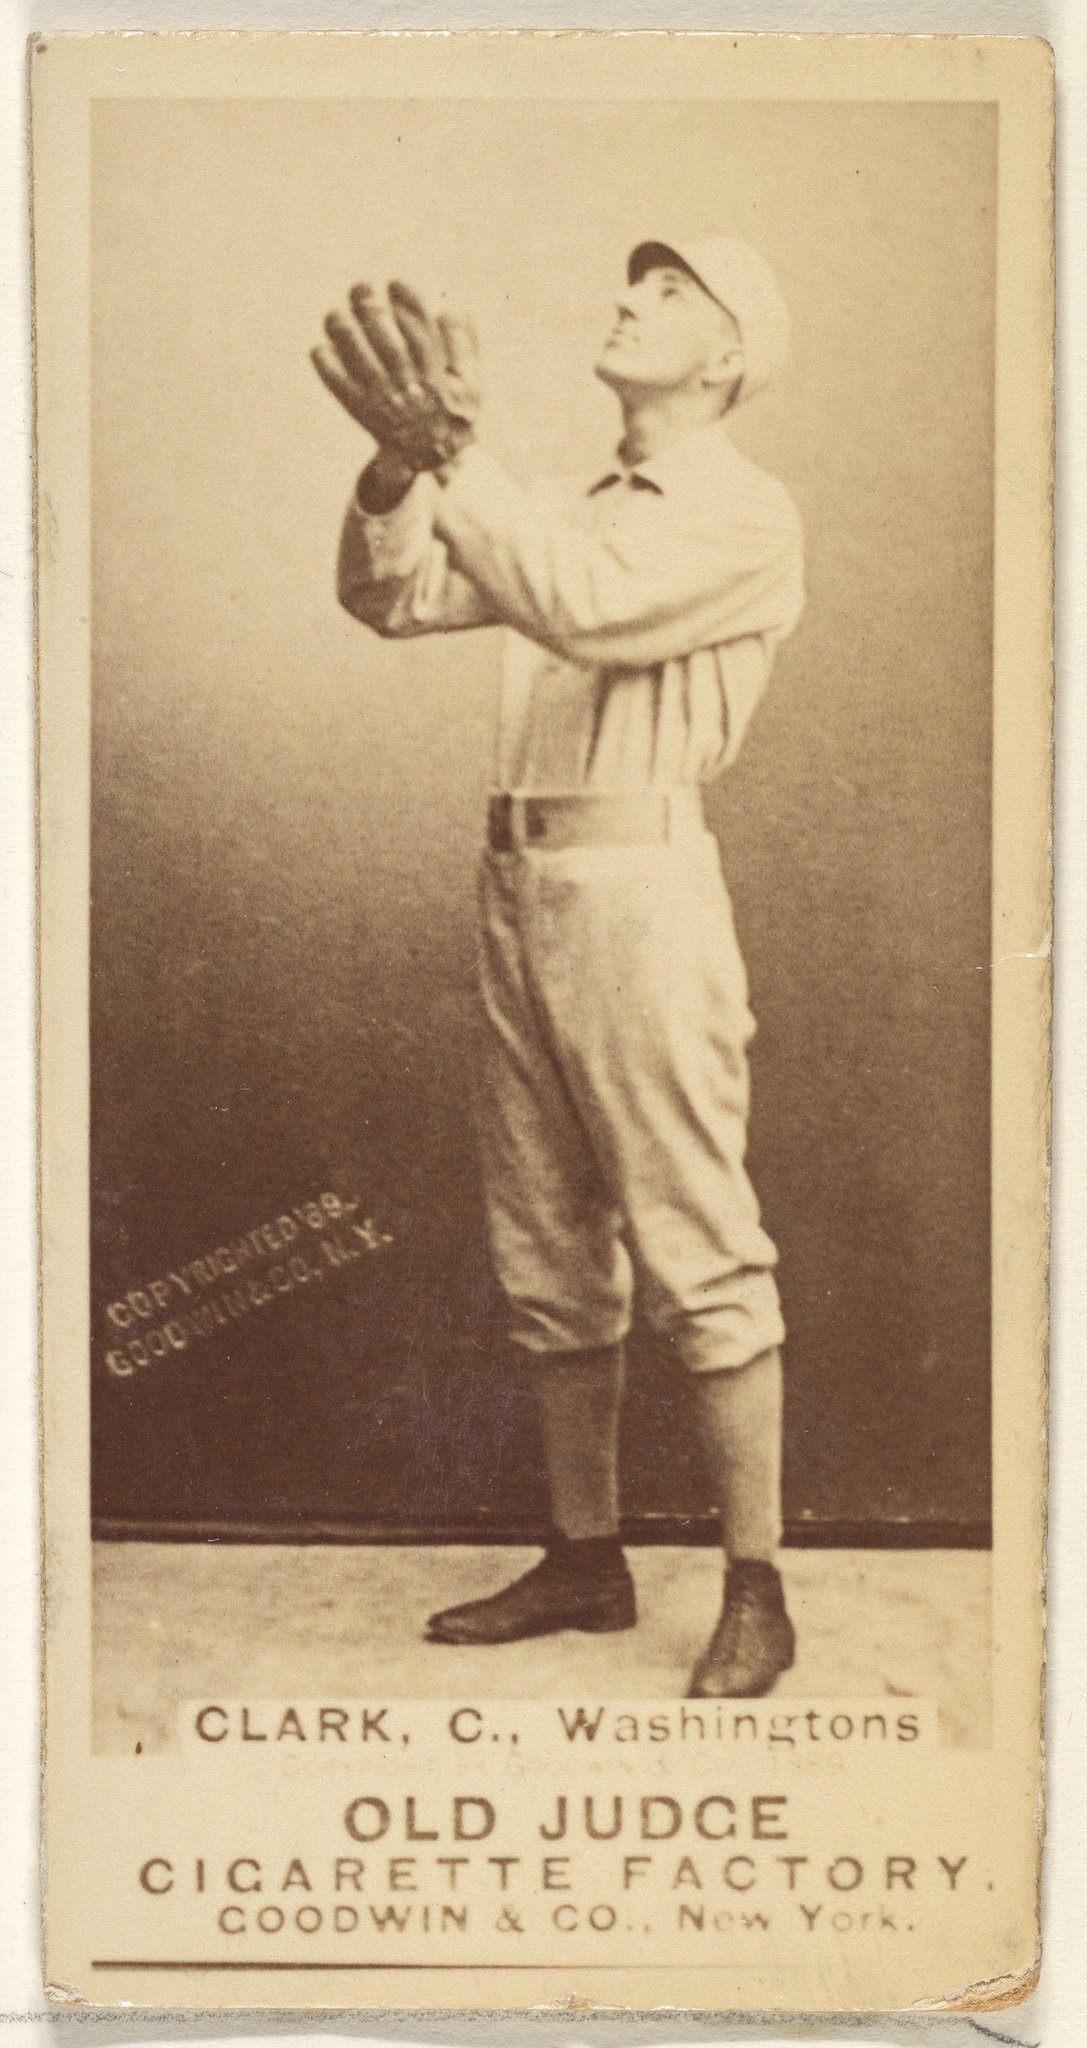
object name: baseball card, photograph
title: Owen F. "Spider" Clark, Catcher, Washington Nationals, from the Old Judge series (N172) for Old Judge Cigarettes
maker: goodwin & company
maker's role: publisher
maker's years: 1850-1950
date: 1889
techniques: albumen silver print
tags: men,portraits,baseball,athletes